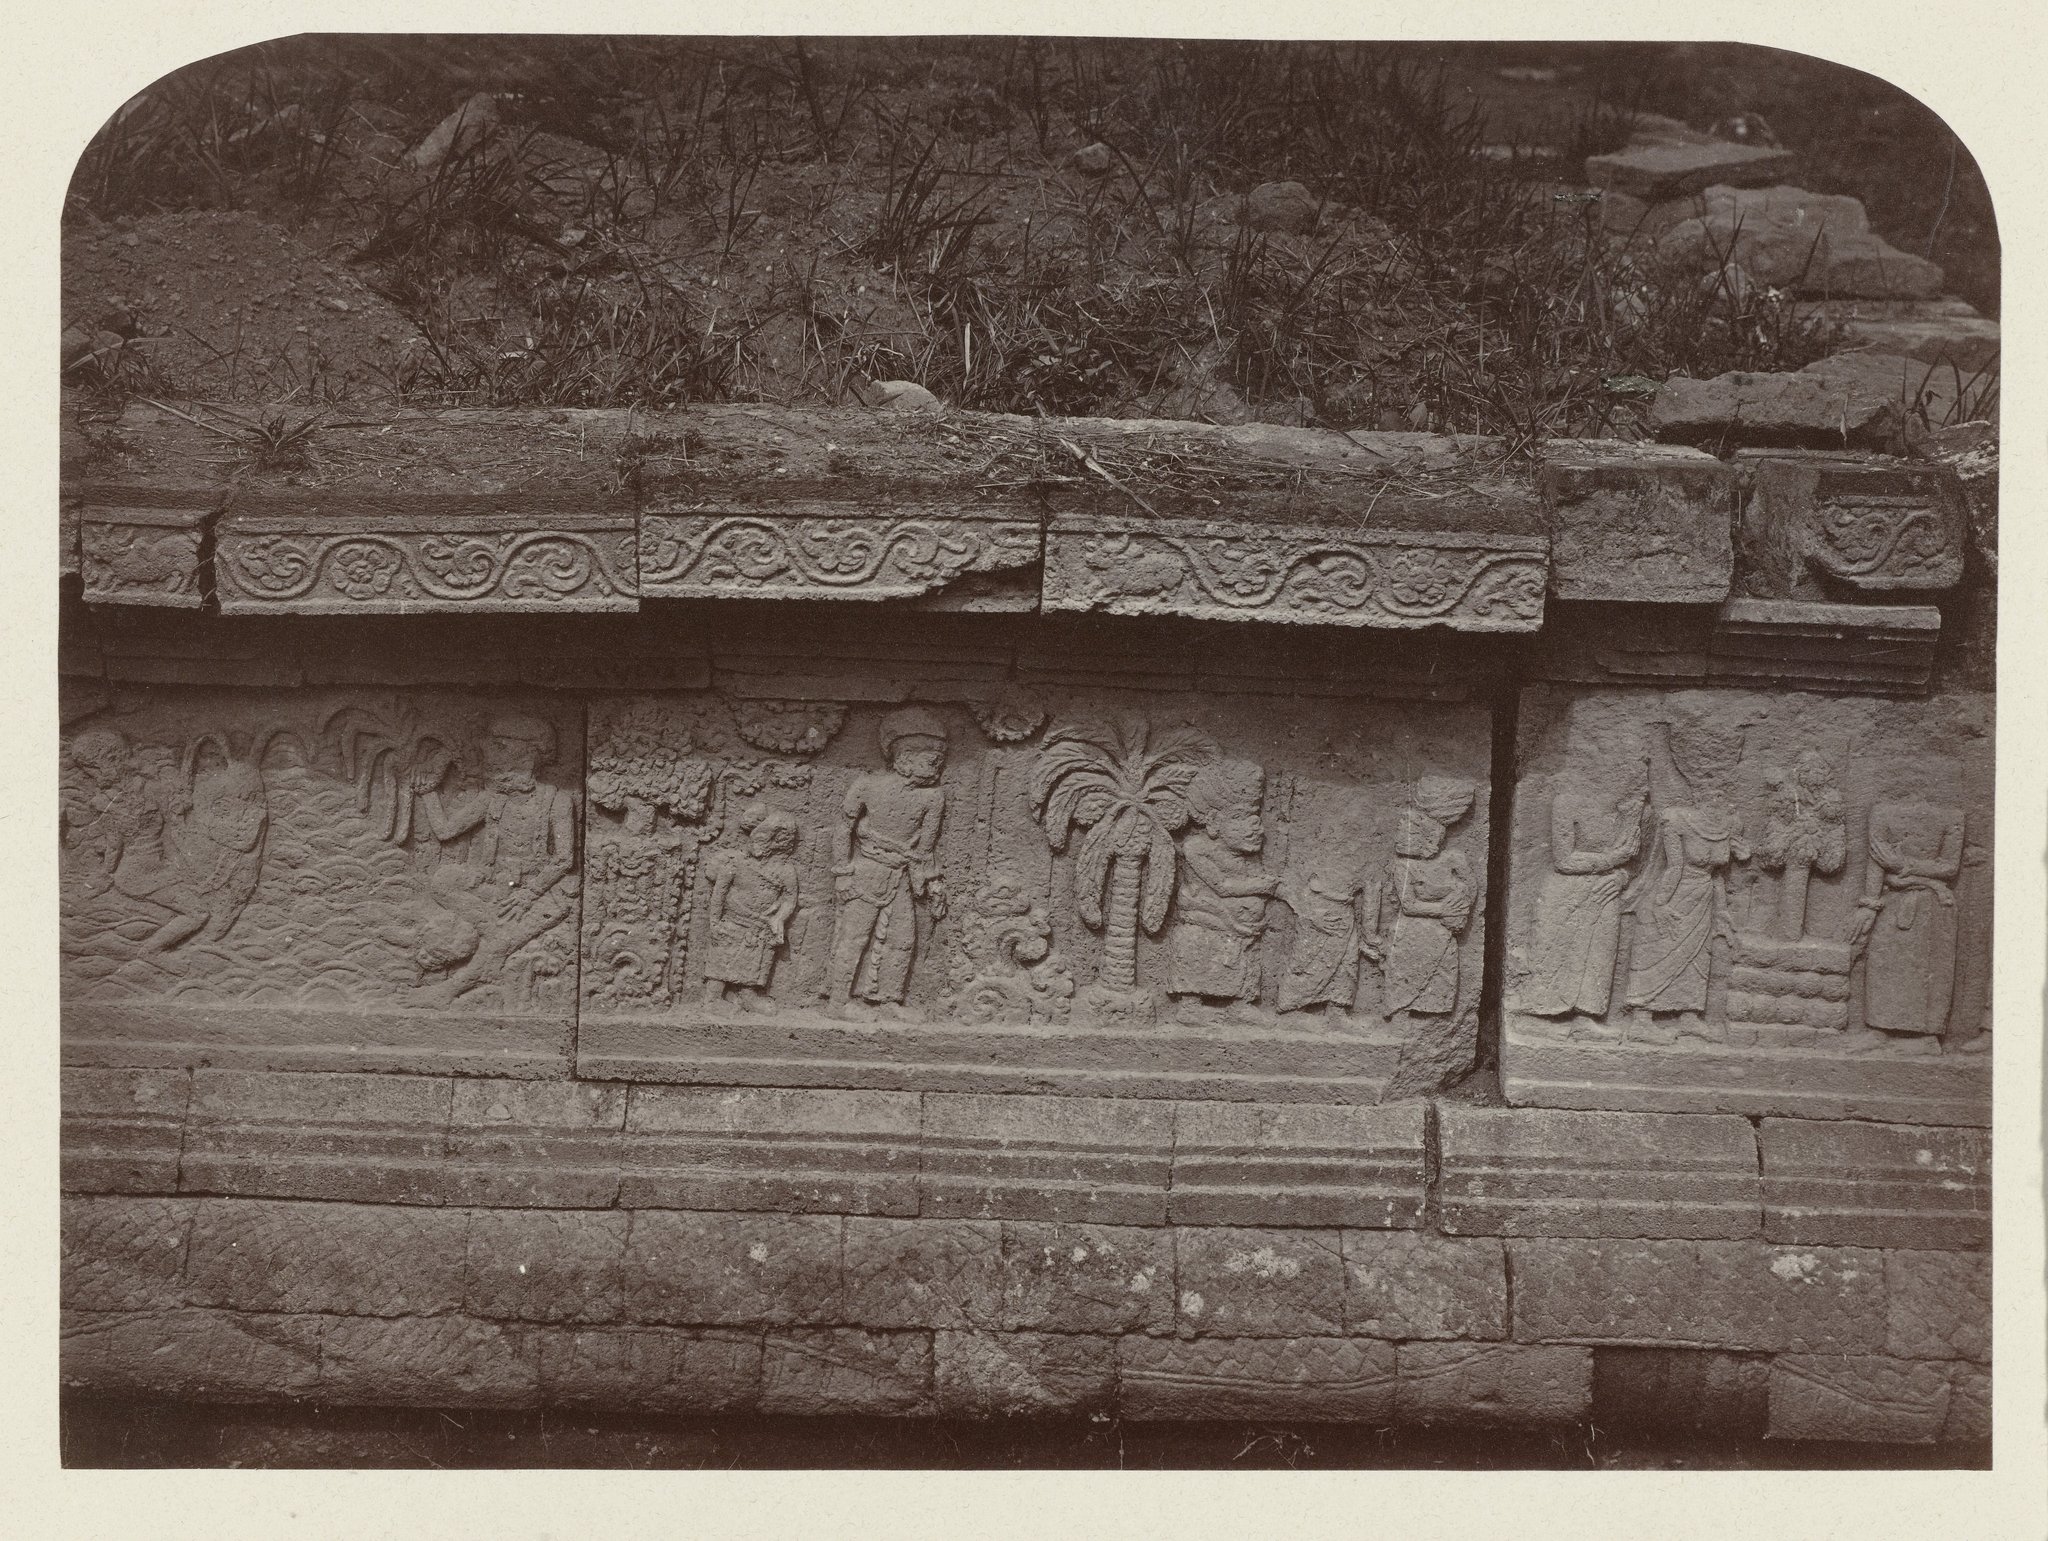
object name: photograph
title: Basrelief op het voetstuk eener pendopo (?) (westzijde). Panataran (r. Kediri)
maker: isidore kinsbergen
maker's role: fotograaf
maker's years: 1821-1905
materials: cardboard, paper, photographic support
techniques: albumen print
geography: java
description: Candi Panataran (Temple Complex), Pendopo Terrace, unidentified reliefs 70-74 (sri Tanjung story; inscription between no. 71-72 reads mahisaputah), west side. Panataran, Blitar district, East Java province, 1375 AD